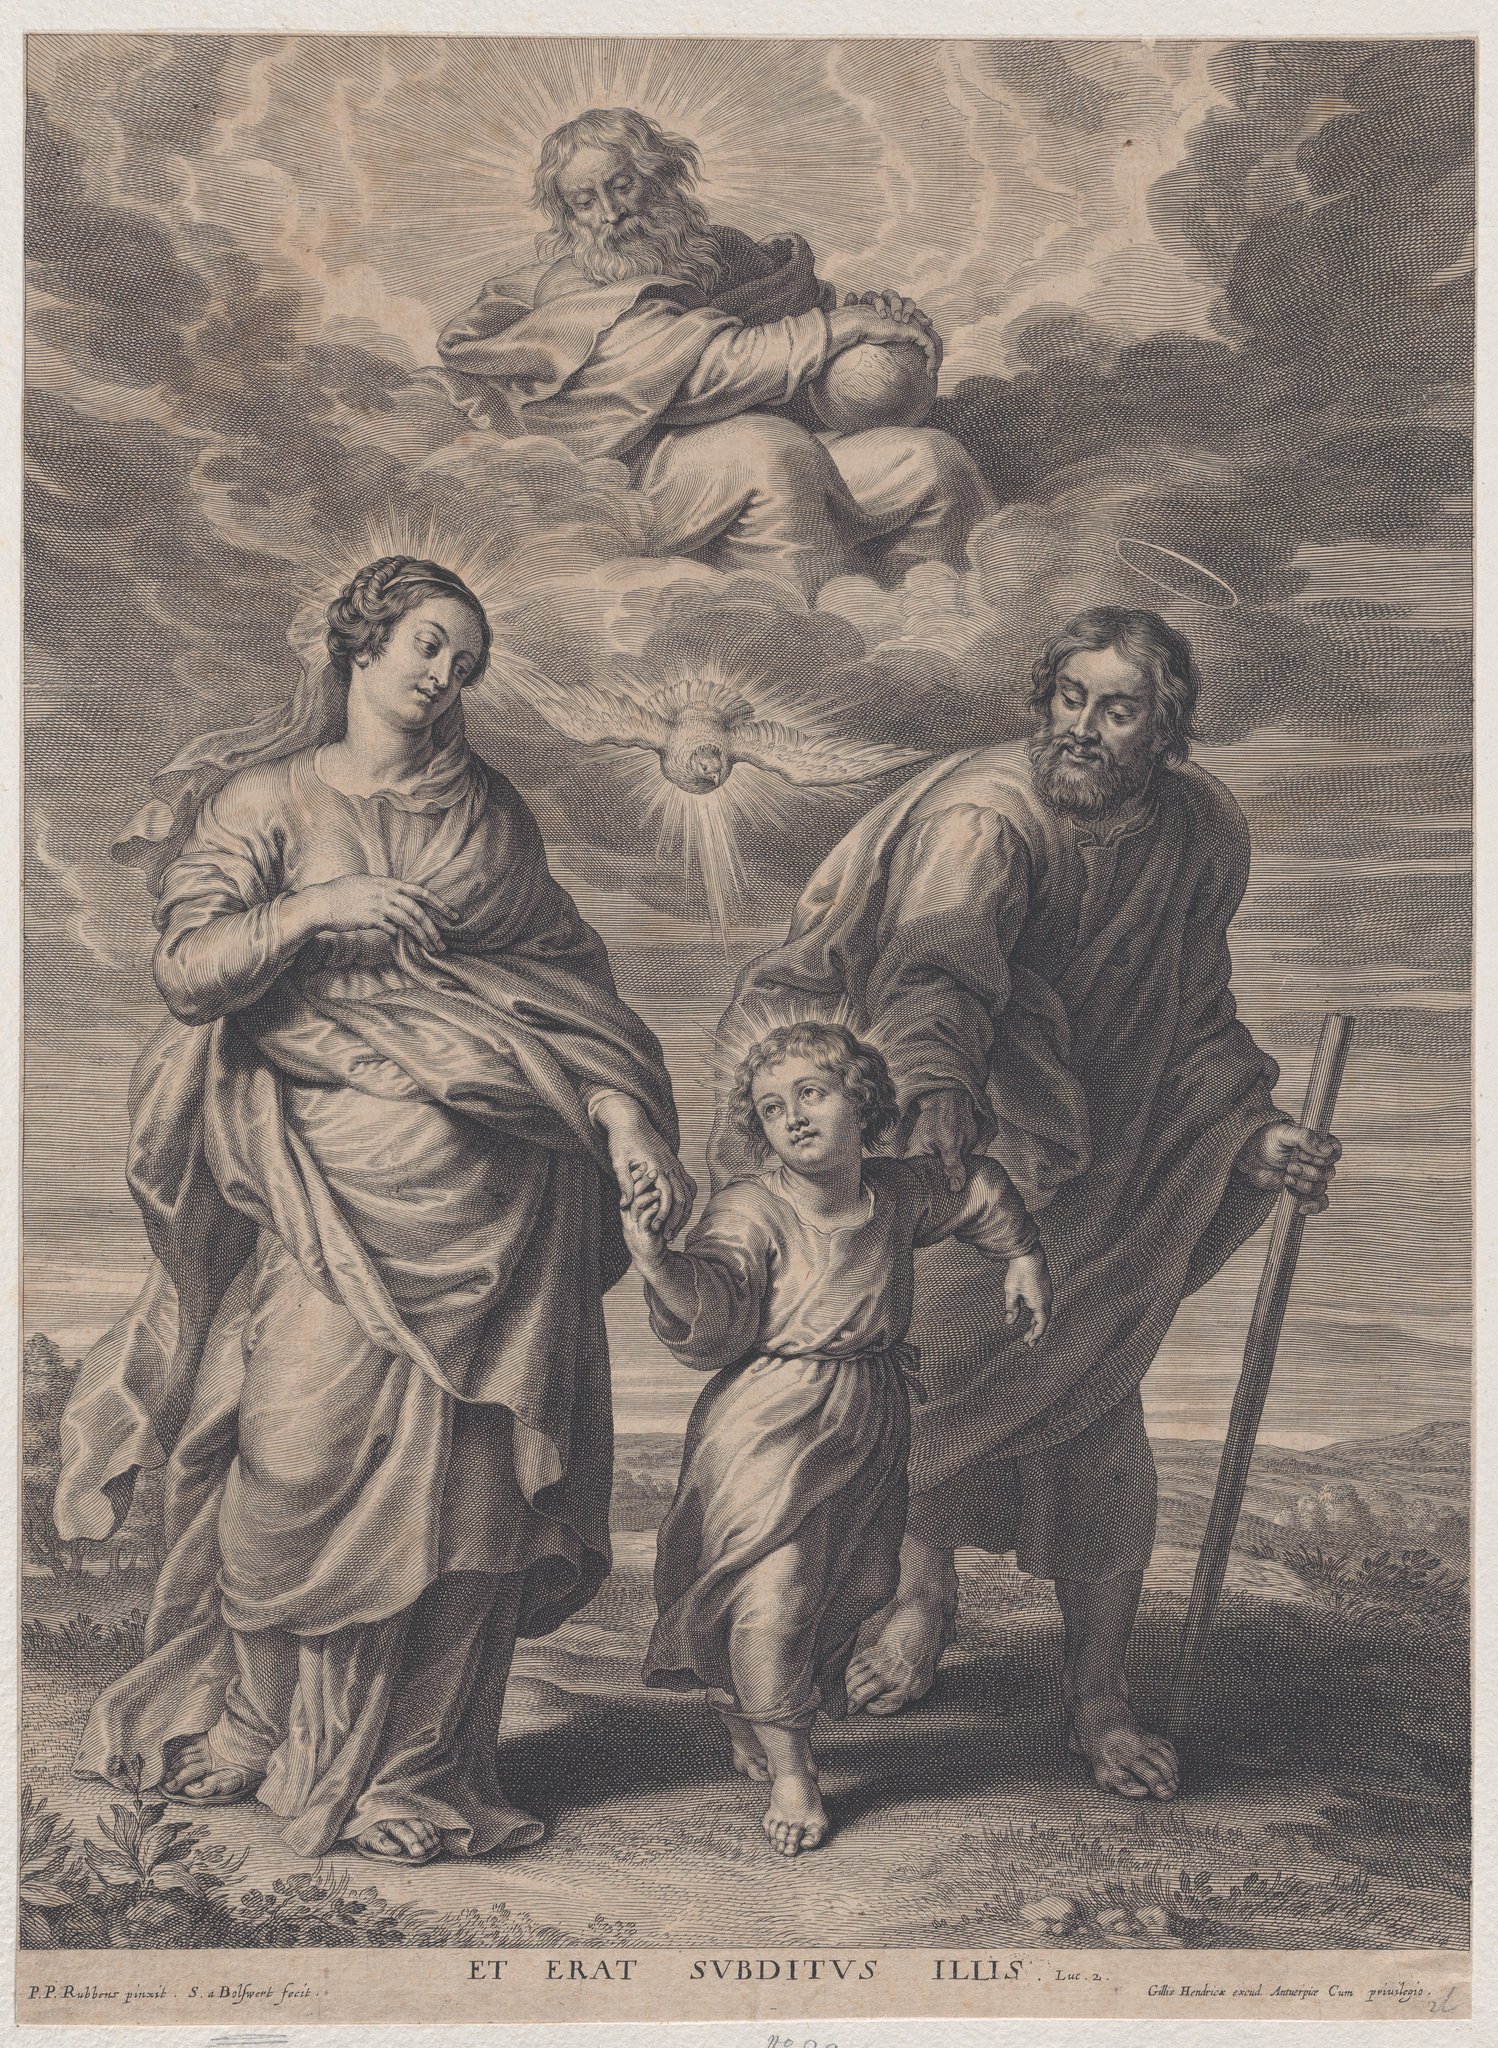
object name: print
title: The Return from Egypt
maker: schelte adams à bolswert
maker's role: artist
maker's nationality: dutch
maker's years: 1581-1659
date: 1595-1659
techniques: engraving